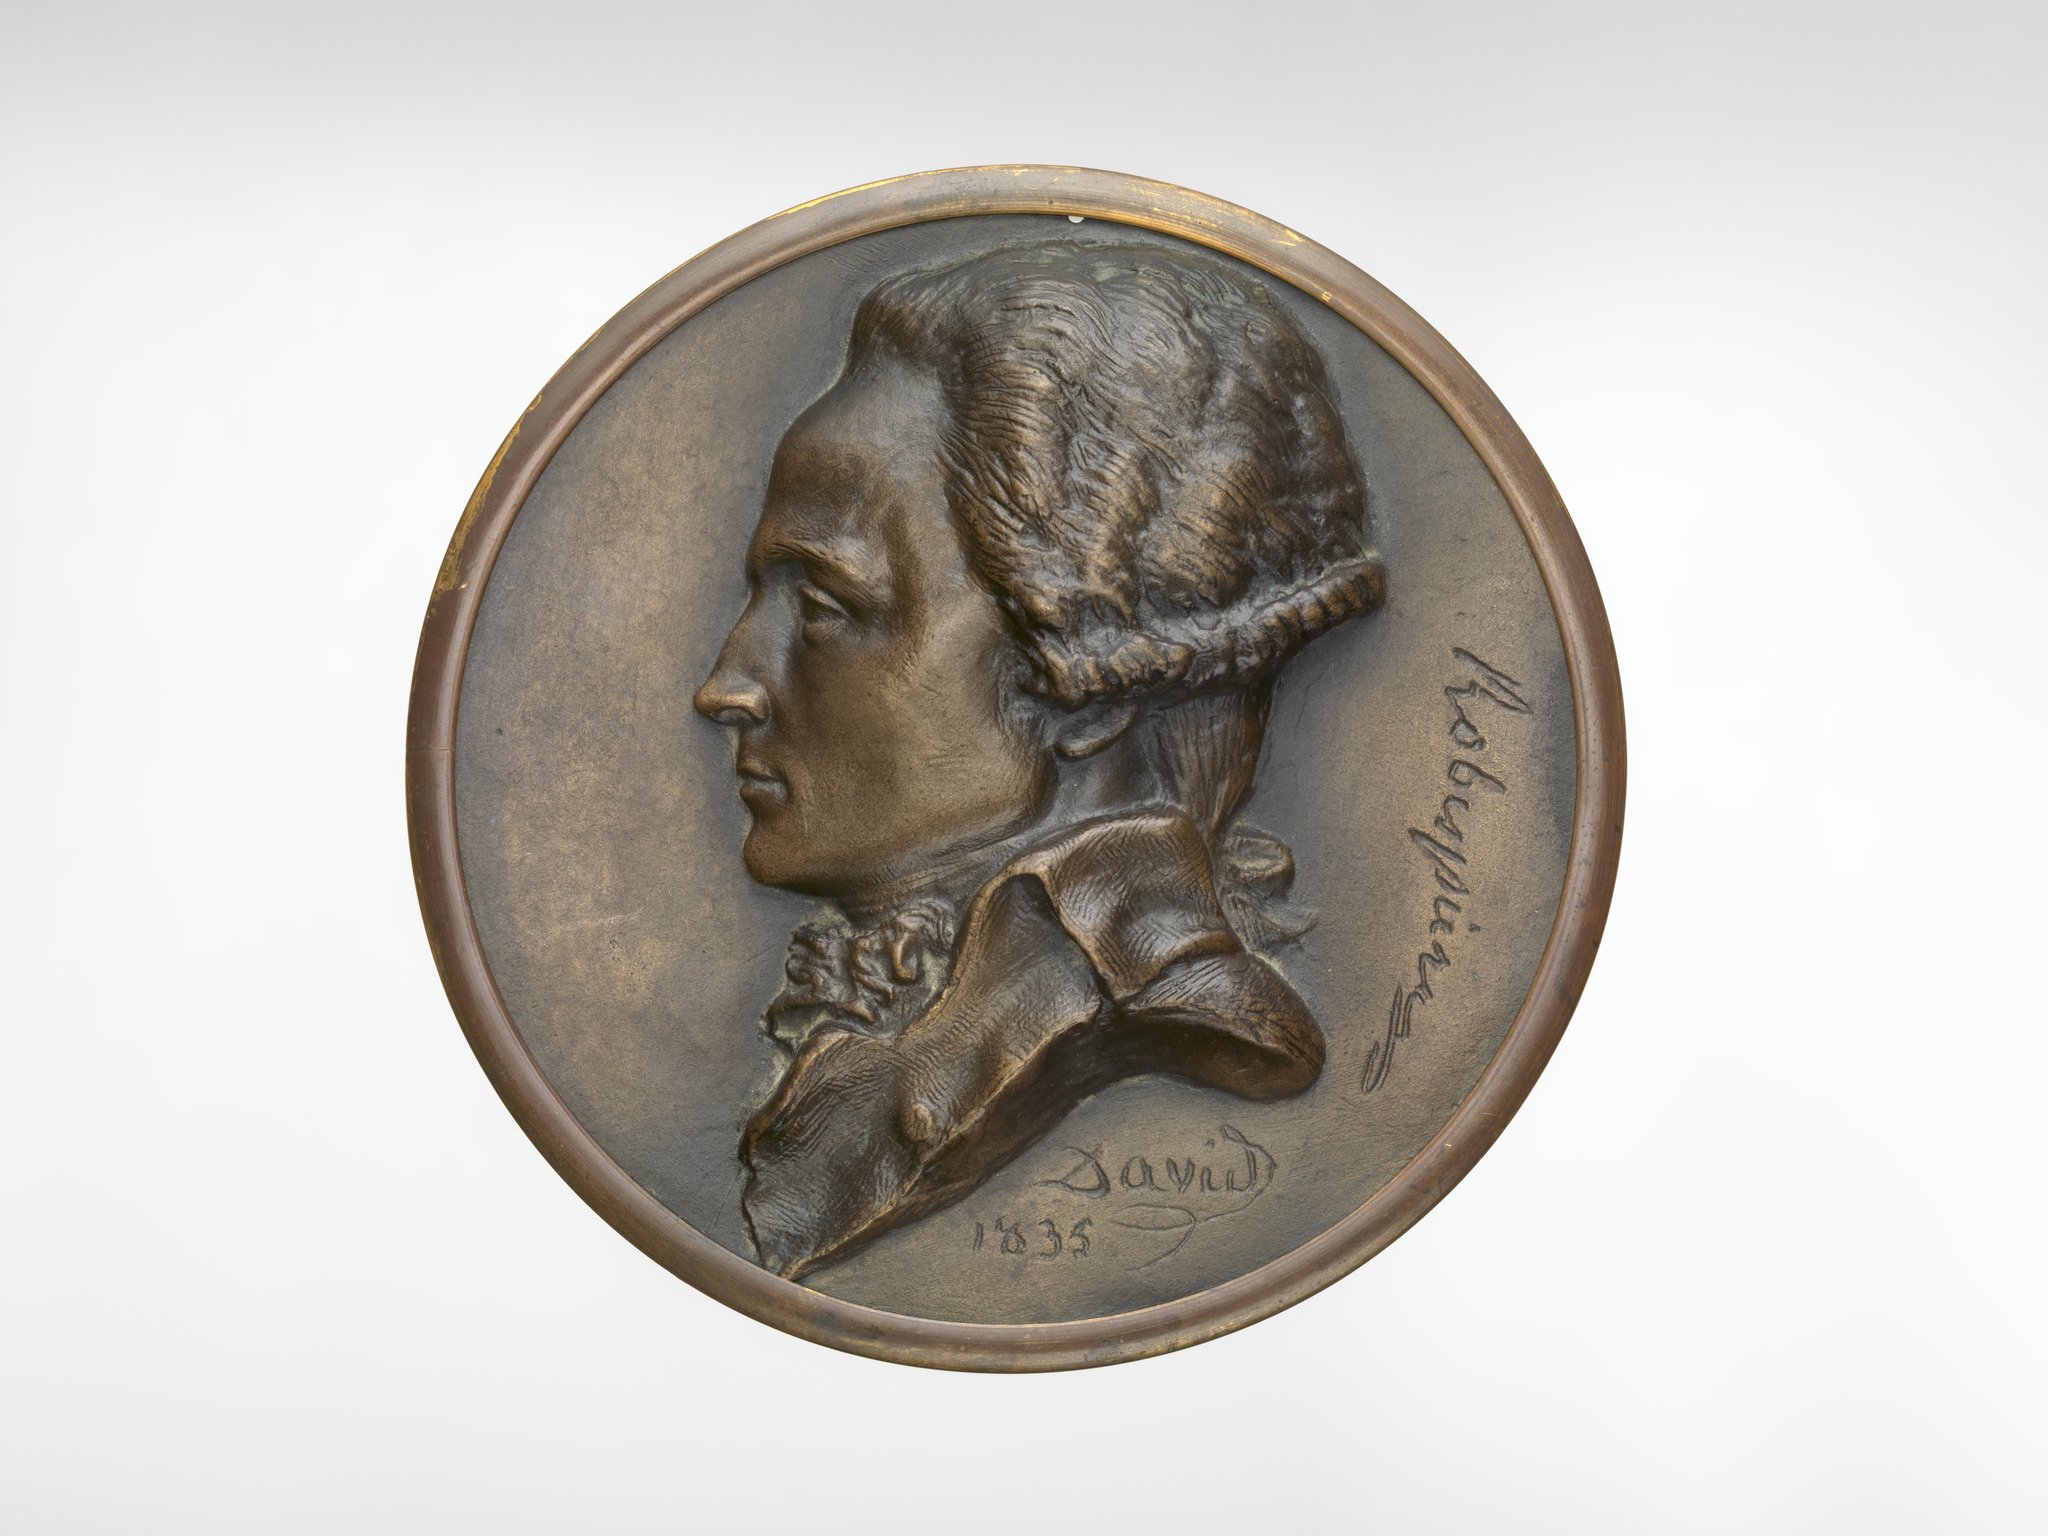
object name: medallion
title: Robespierre (1758–1794)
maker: pierre jean david d'angers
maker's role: maker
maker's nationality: french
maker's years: 1788-1856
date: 1835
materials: bronze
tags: men,portraits